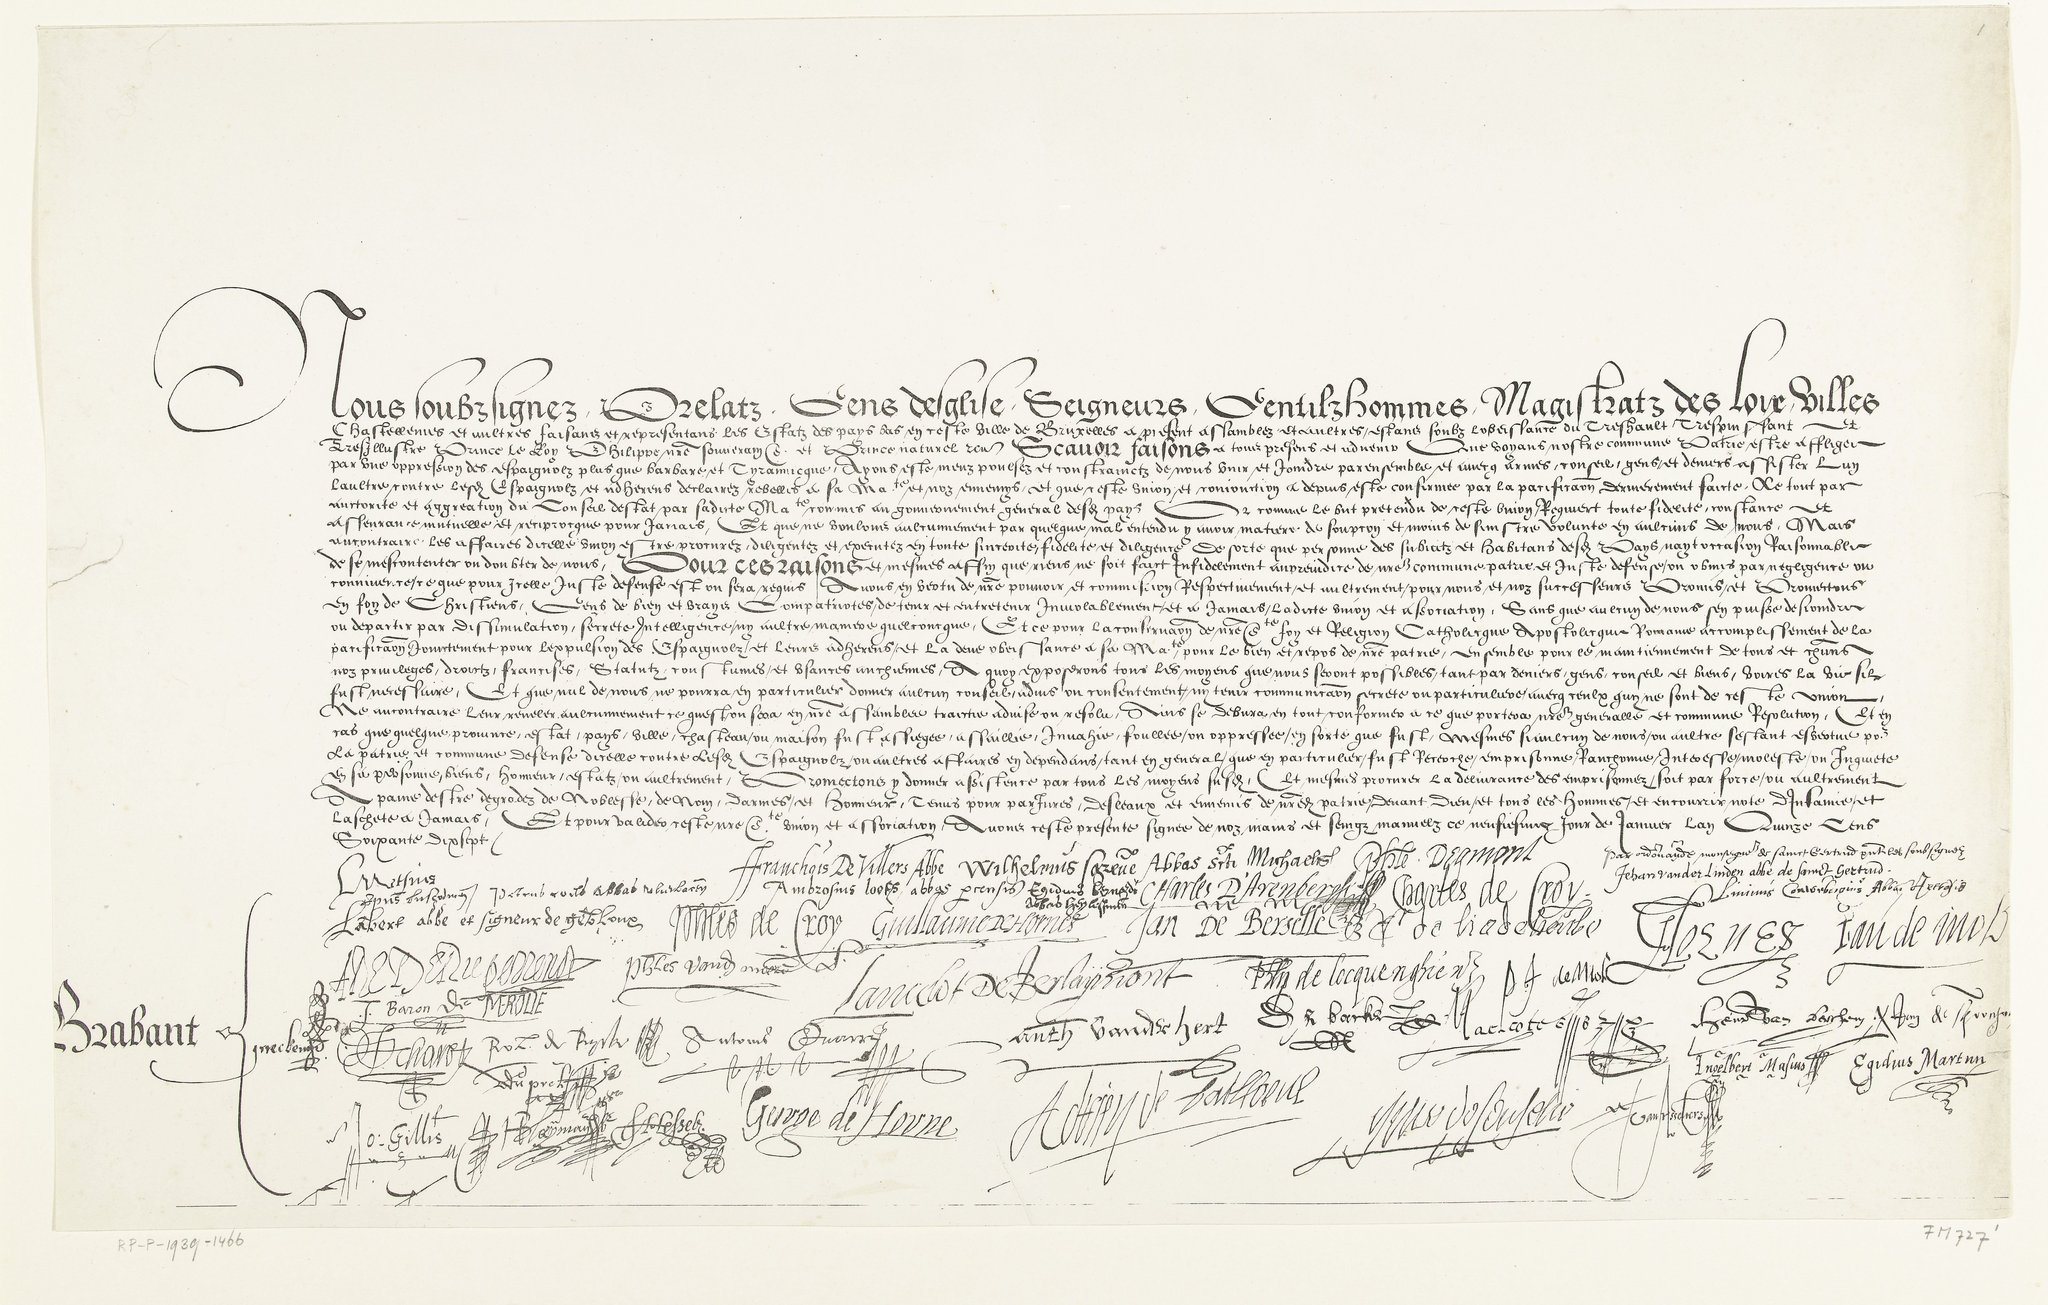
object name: historical object representation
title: Eerste blad van de facsimile van het geschrift van de Unie van Brussel met handtekeningen, 1577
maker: daniël abrahams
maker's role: print maker, printer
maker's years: 1795-1854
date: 1827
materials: paper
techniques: lithograph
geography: the hague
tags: unie van brussel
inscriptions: collector's mark: Lugt 2760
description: Eerste blad van de facsimile van het geschrift van de Unie van Brussel met handtekeningen, 9 januari 1577.